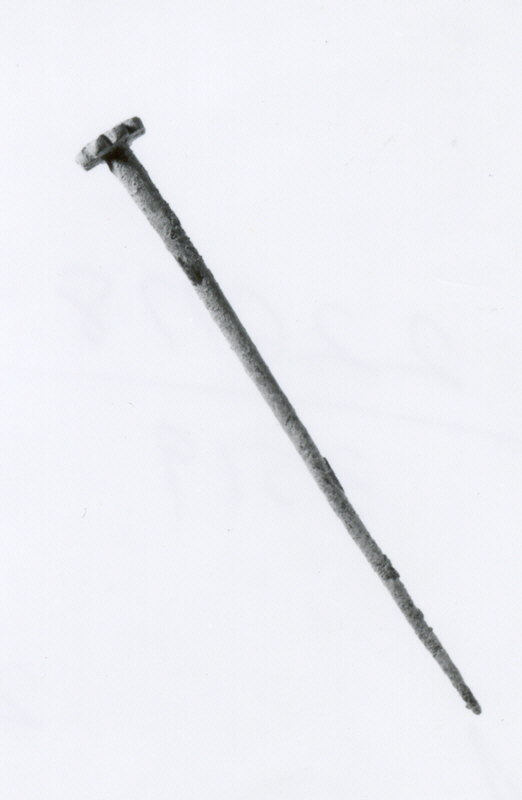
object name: pin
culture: bactria-margiana archaeological complex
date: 2333-1668 BCE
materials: copper alloy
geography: bactria-margiana